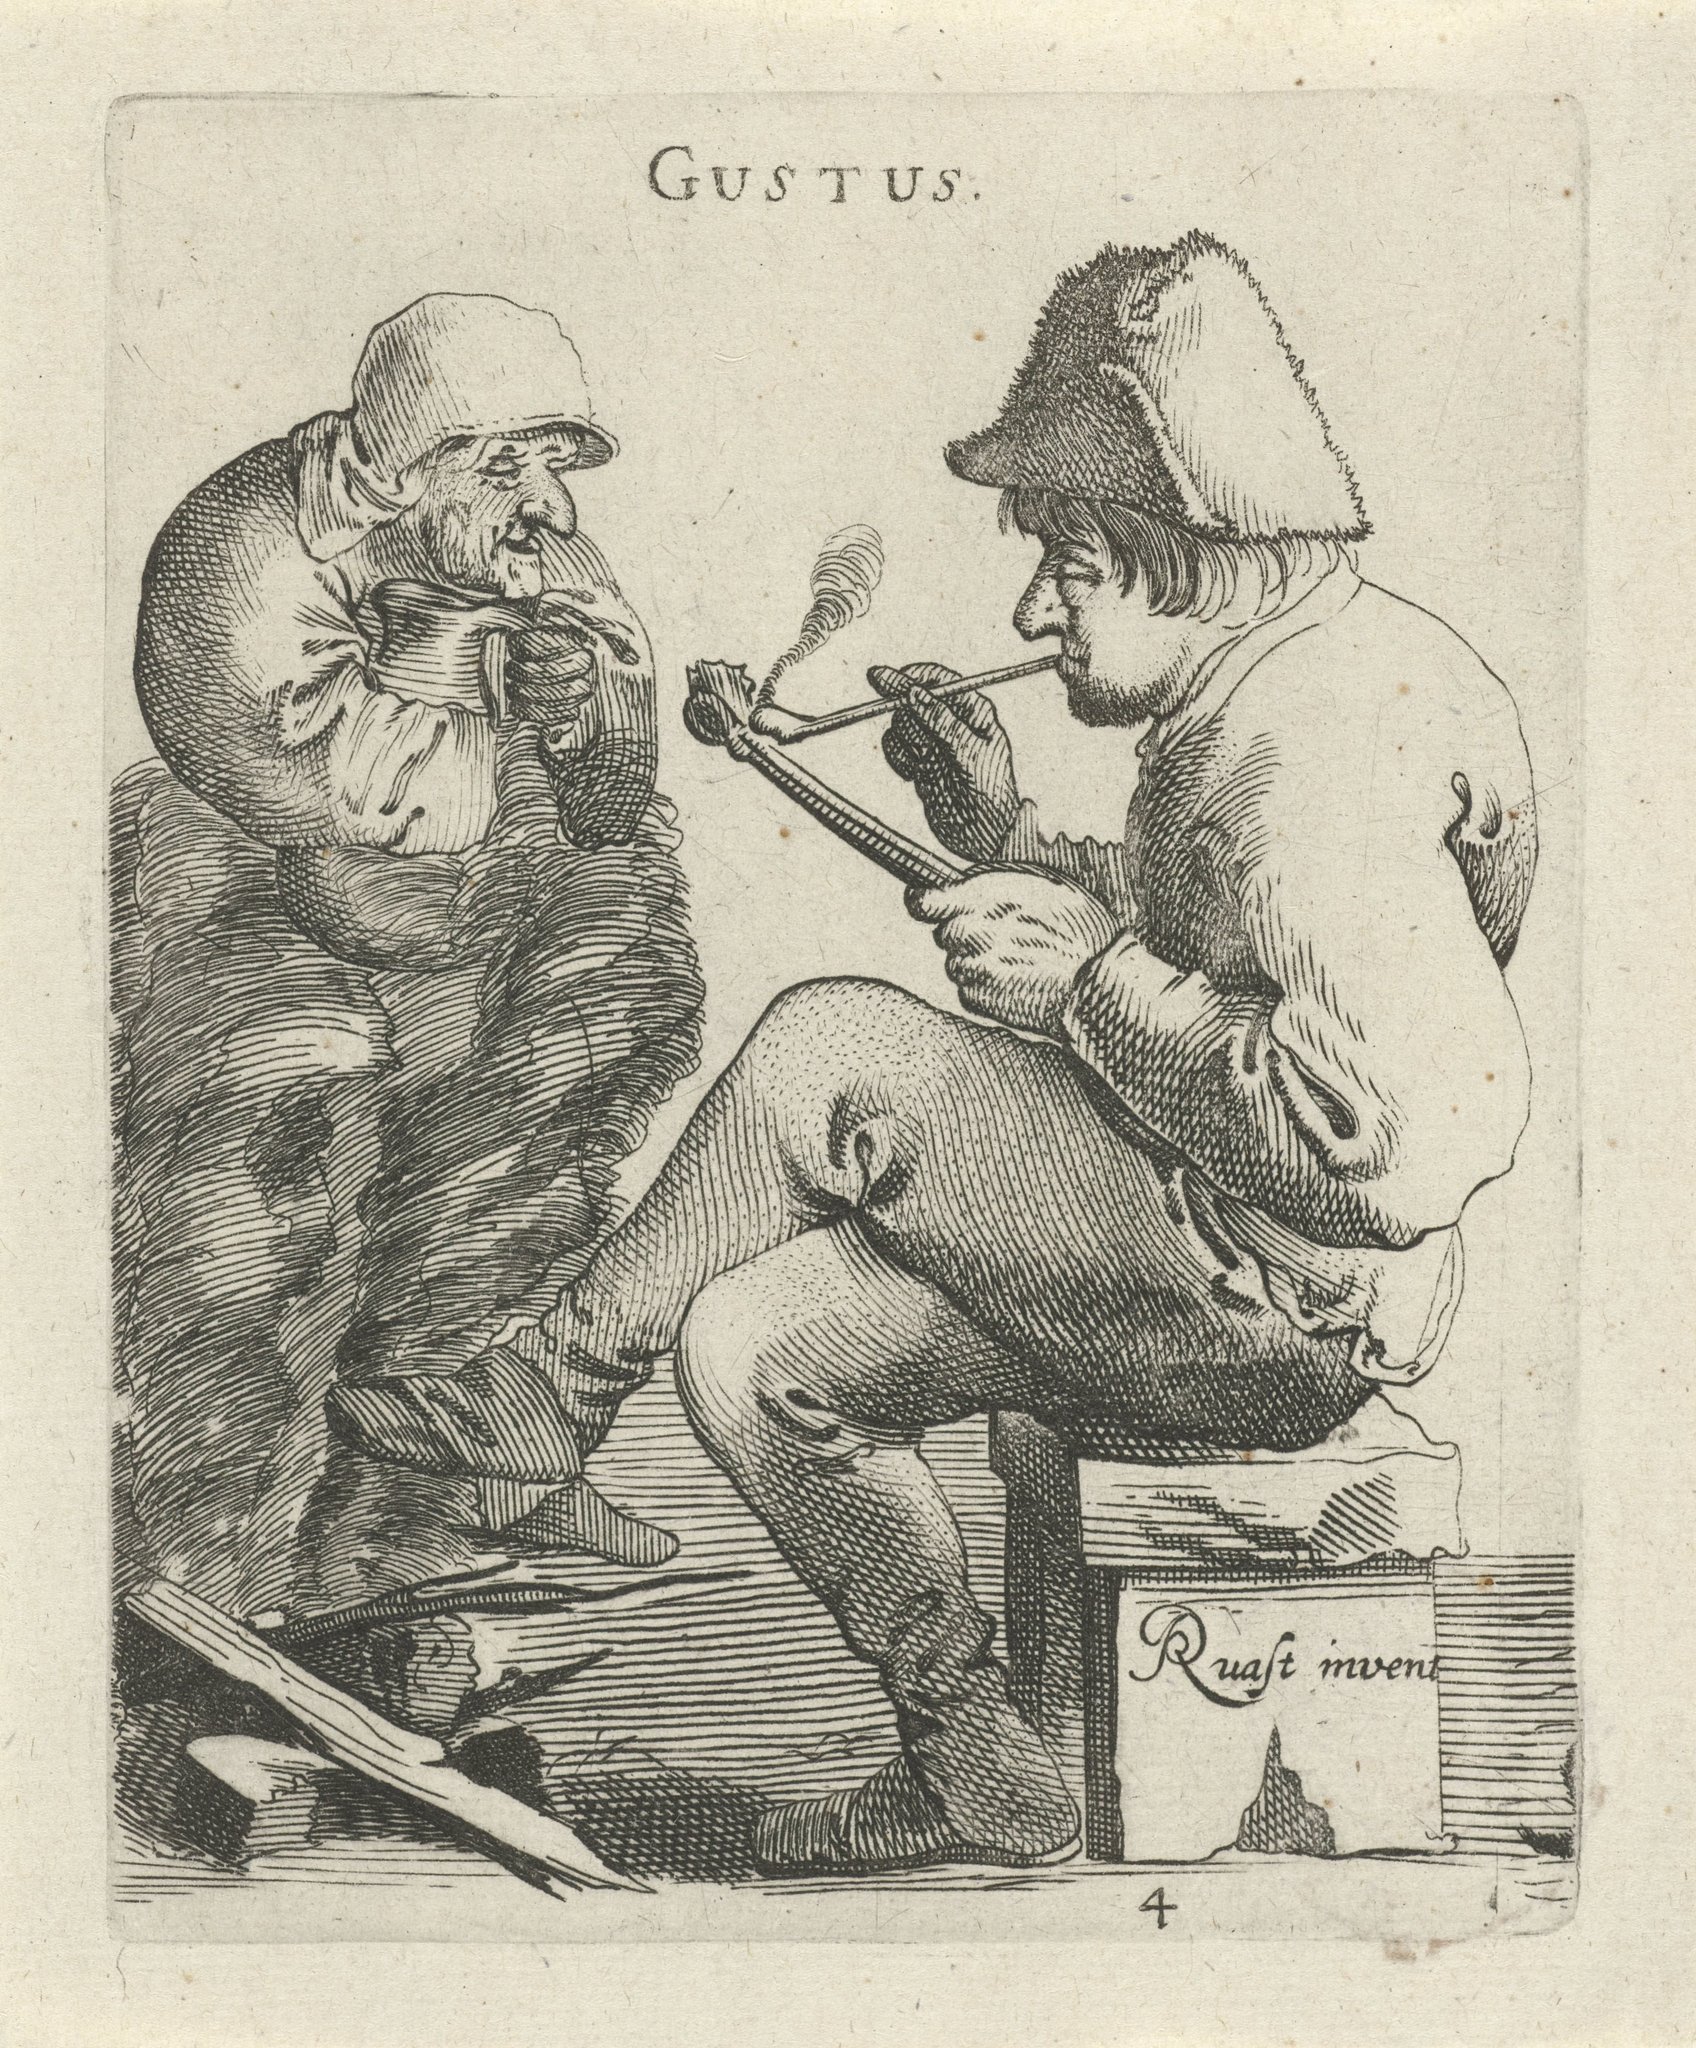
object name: print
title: Gustus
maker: pieter jansz quast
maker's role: draughtsman, painter, print maker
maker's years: 1605-1647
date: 1638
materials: paper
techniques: engraving, etching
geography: the hague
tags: taste, tasting (one of the five senses), pipe ~ tobacco, drinking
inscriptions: collector's mark: Lugt 240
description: Op een bankje zit een man een pijp te roken. Tegenover de man houdt een persoon een grote schenkkan met drank onder de kin. De prent maakt deel uit van een serie van zes prenten met de vijf zintuigen.